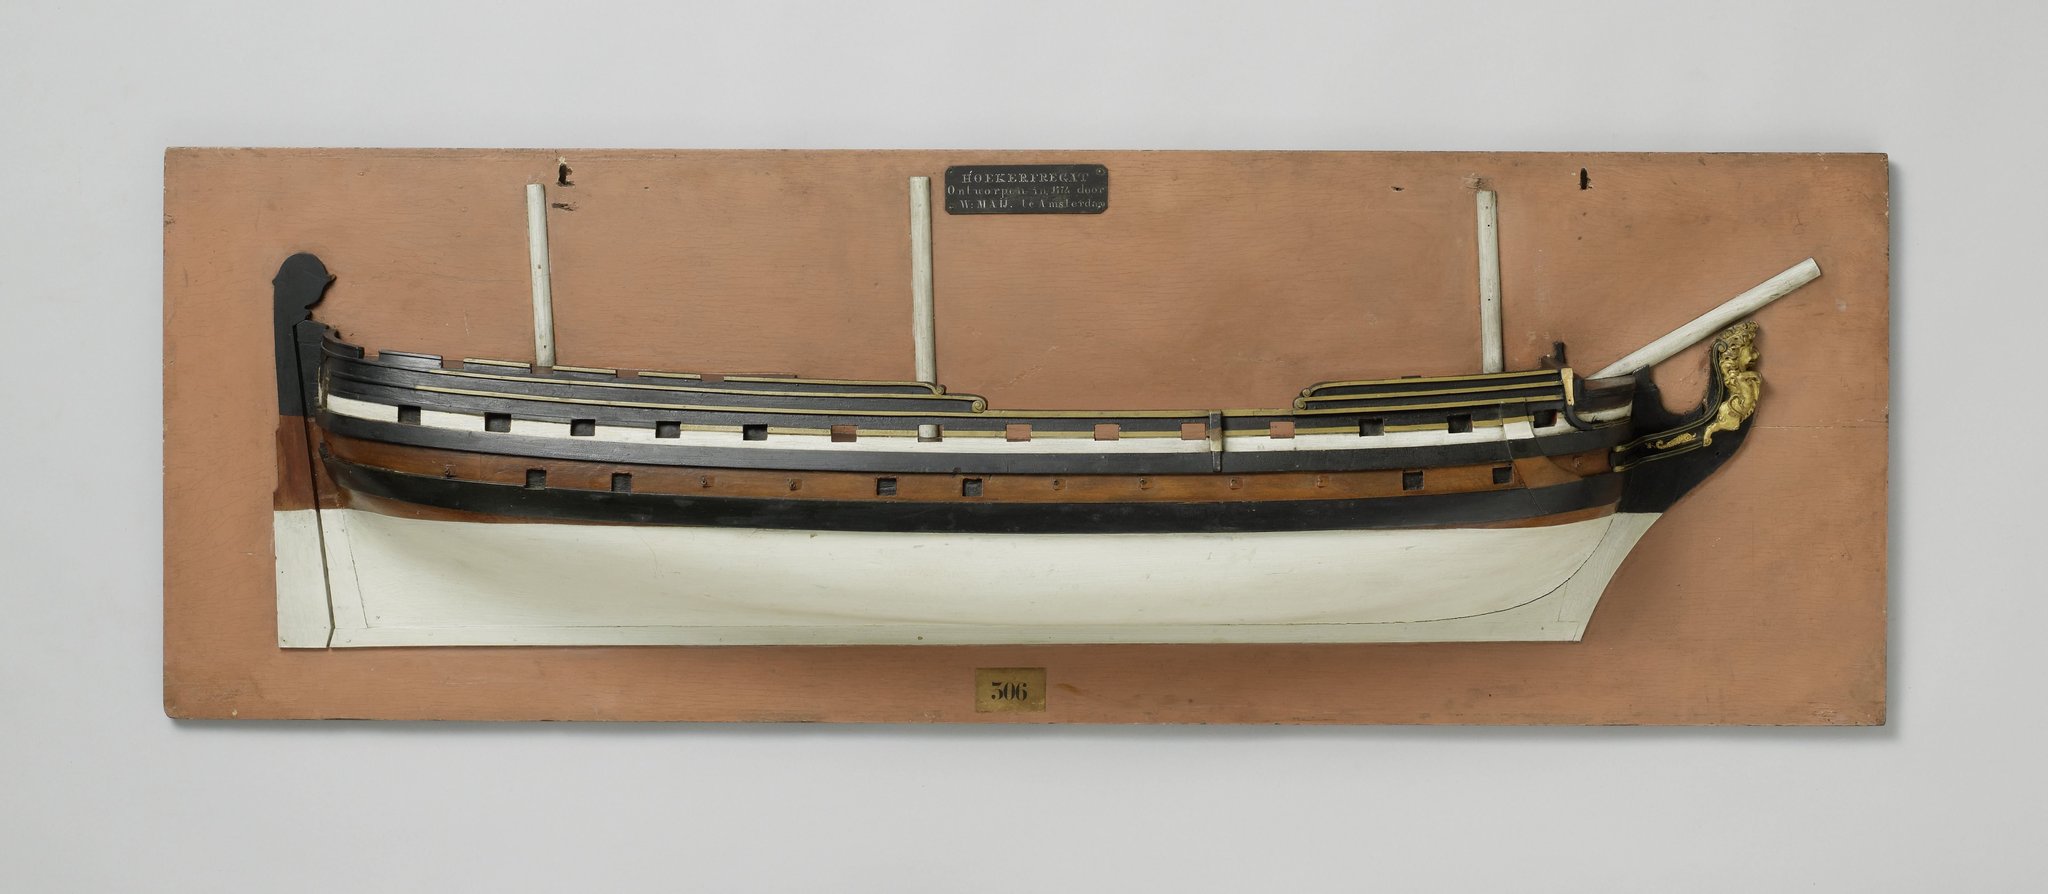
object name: builder's model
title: Half Model of a 40-Gun Hooker Frigate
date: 1774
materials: wood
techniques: polychromy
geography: amsterdam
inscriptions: label, bottom centre: ‘306’ former inventory label, inscription, top centre, on a rectangular black label: ‘HOEKERFREGAT / Ontworpen in 1774 door / W: MAIJ. te Amsterdam’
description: Gepolychromeerd blokmodel (stuurboord) van een driemaster. Zeven en twintig geschutspoorten verdeeld over drie dekken. Uitgewerkt galjoen met gekroonde leeuw als schegbeeld en dolfijn op de slooiknie. Rond achterschip met twee grote lichten, geen details van hek of zijgalerij. Achtersteven en roer lopen door tot het bovendek; recht roer met vierkante roerkoning en roerkop in de vorm van een silhouet van een menselijk hoofd. Zeeg aan beide uiteinden iets oplopend, twee barkhouten en één reehout. Gepiekt rondspant.